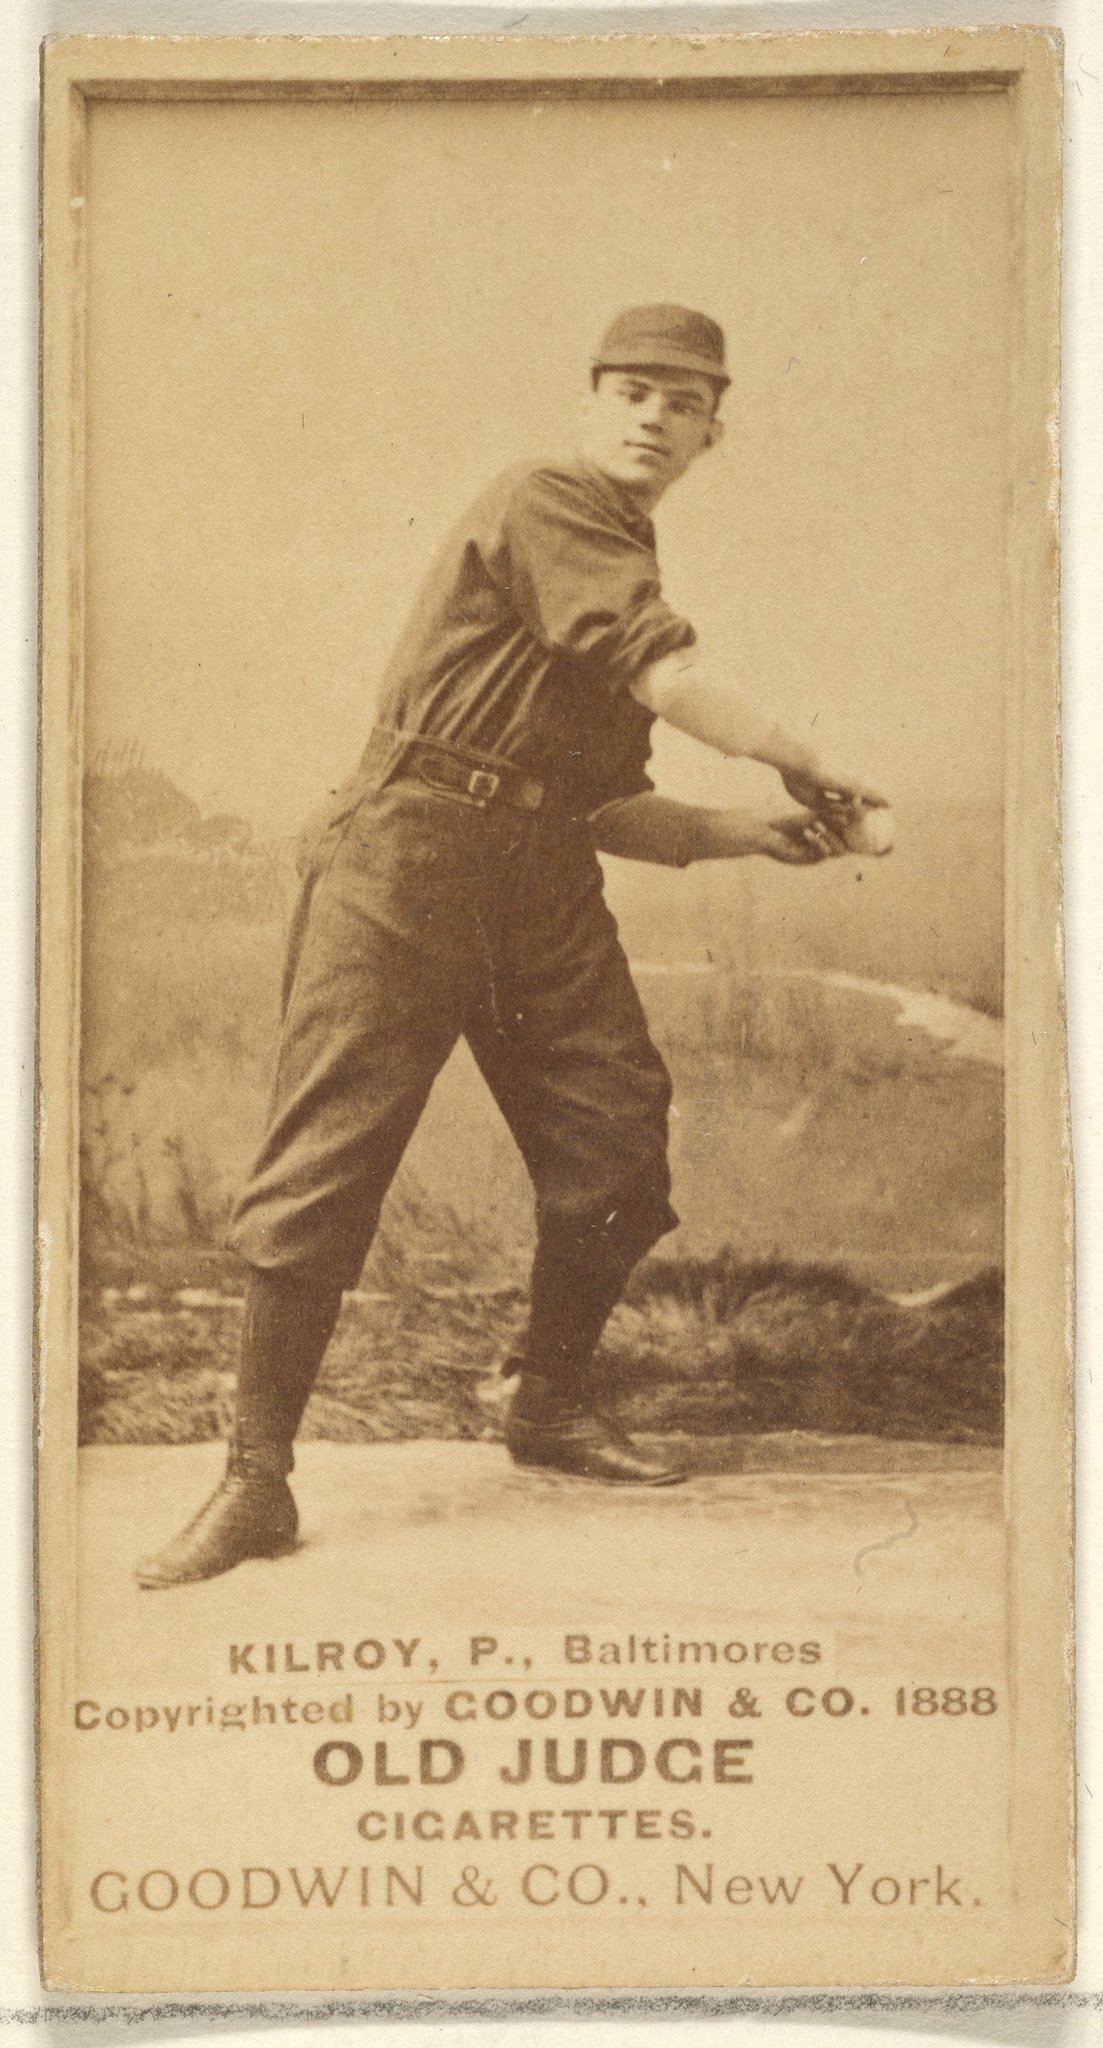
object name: baseball card, photograph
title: Kilroy, Pitcher, Baltimore Orioles, from the Old Judge series (N172) for Old Judge Cigarettes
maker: goodwin & company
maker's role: publisher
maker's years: 1850-1950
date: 1888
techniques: albumen silver print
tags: men,portraits,baseball,athletes